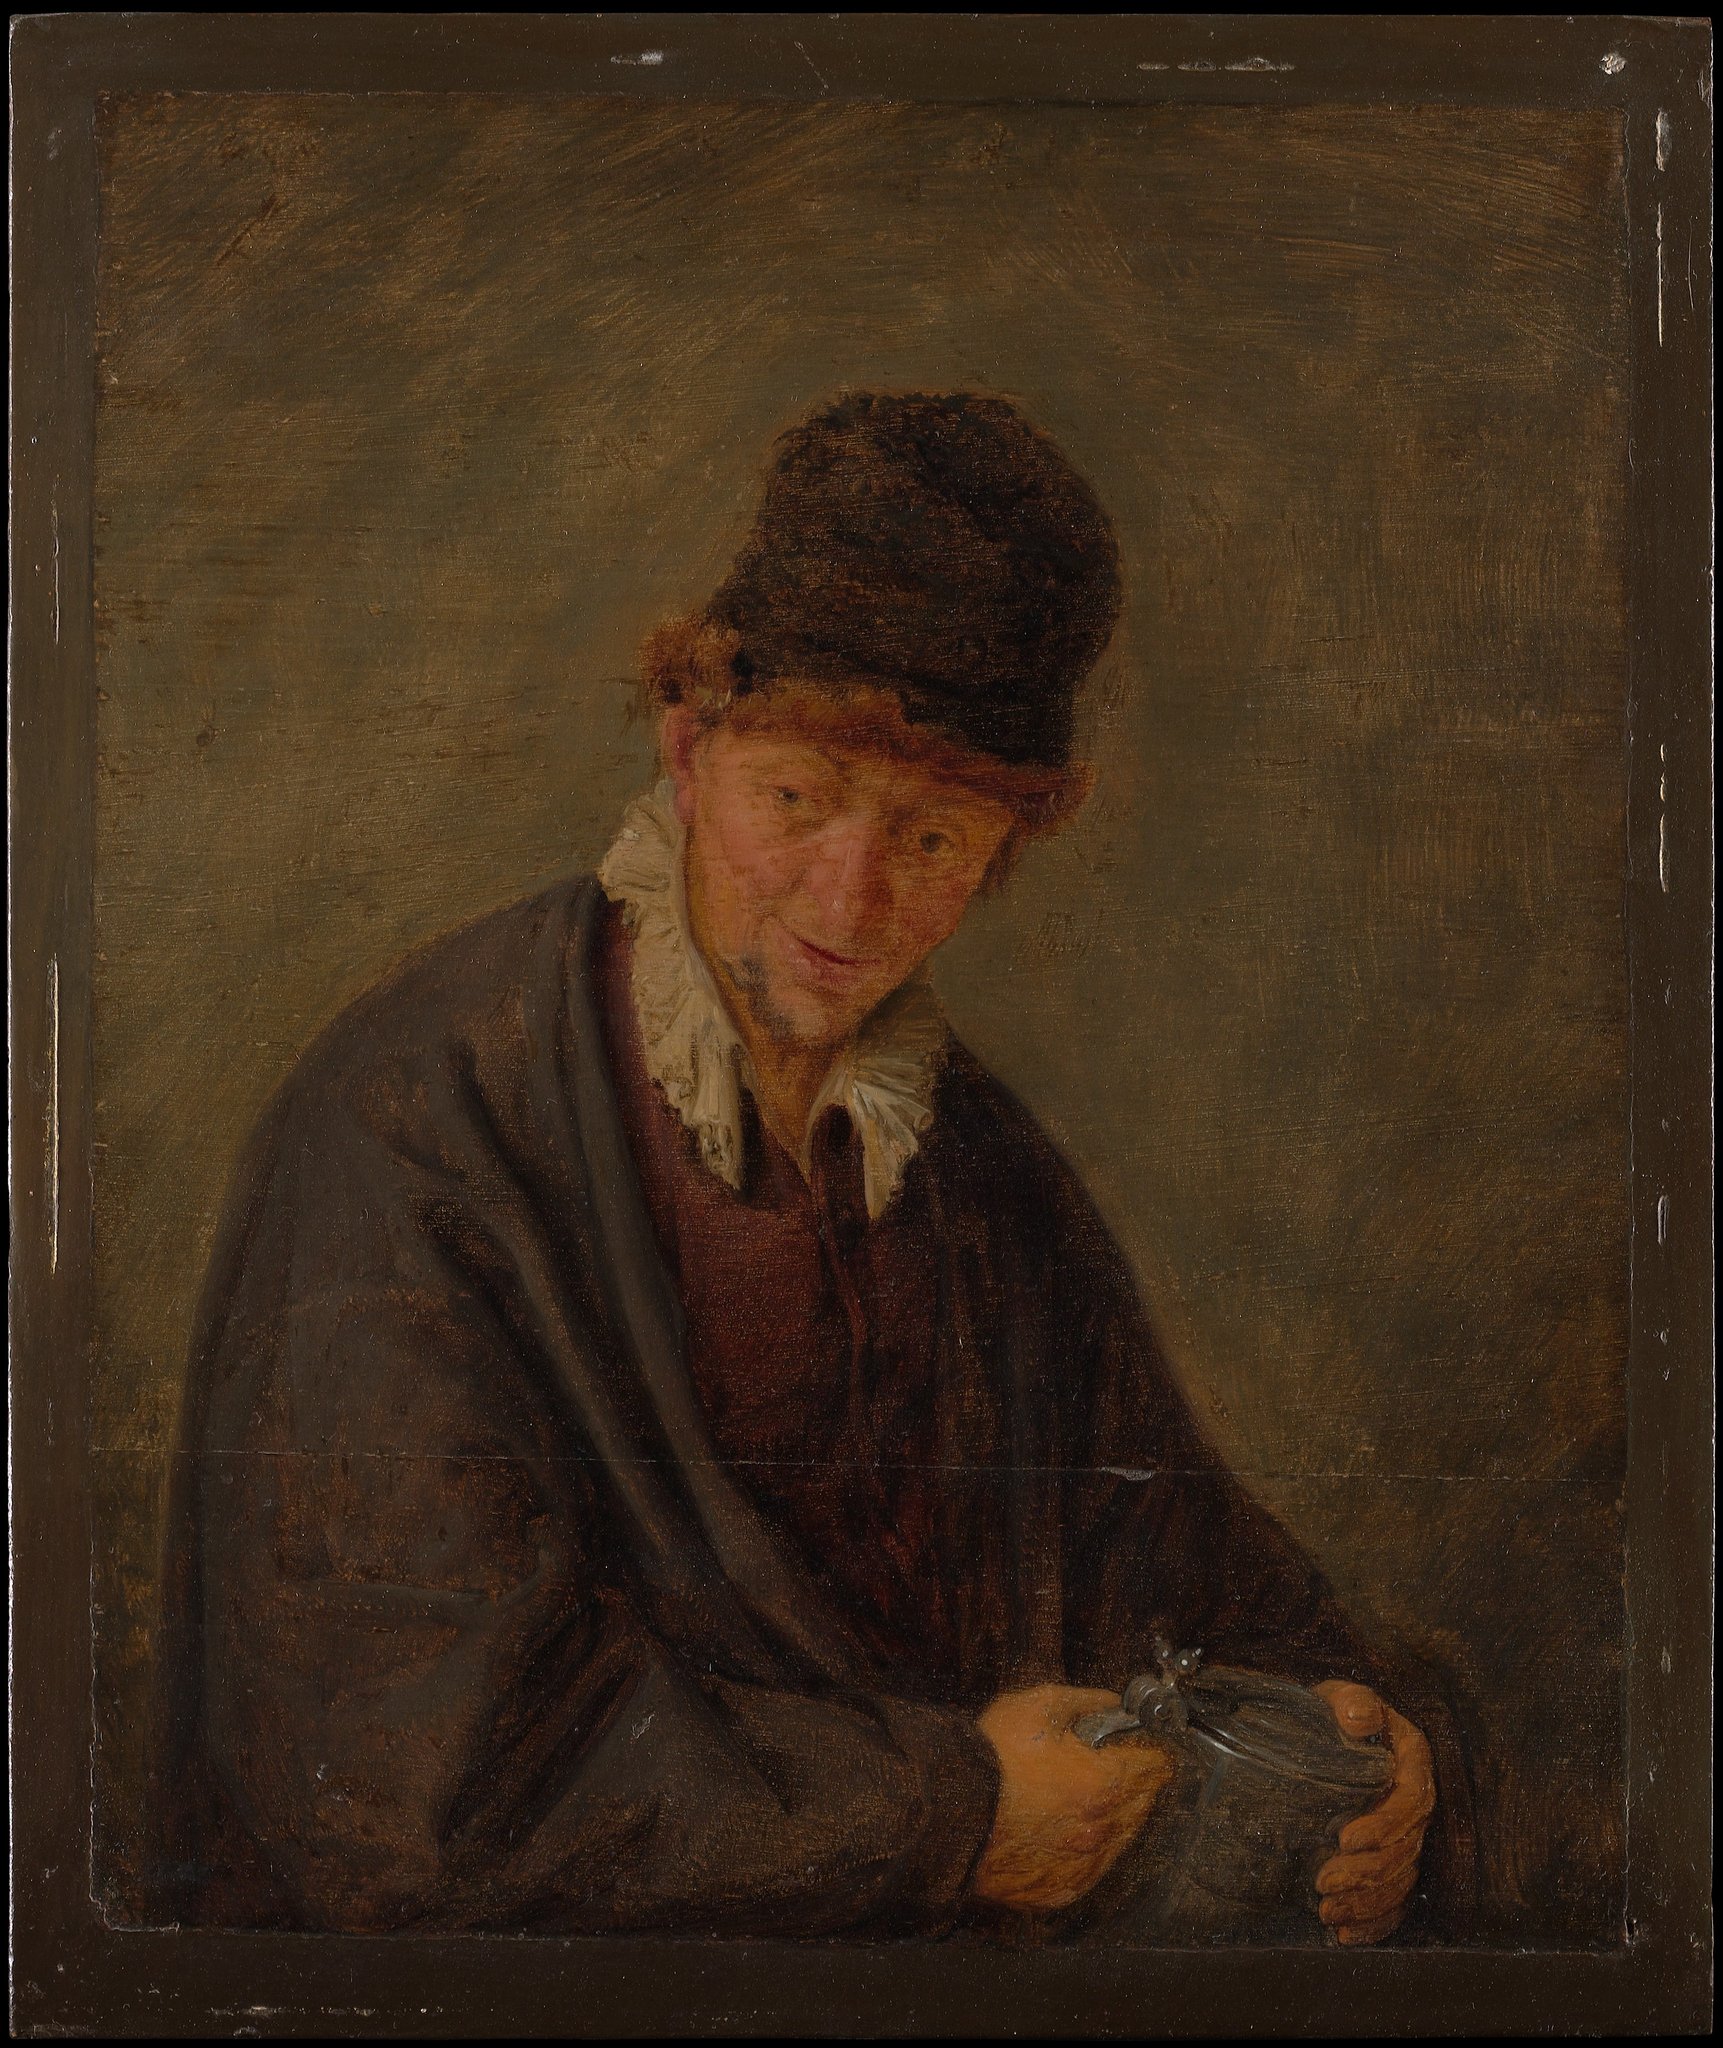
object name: painting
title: Man with a Tankard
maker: adriaen van ostade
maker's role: artist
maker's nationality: dutch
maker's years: 1610-1685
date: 1650-1699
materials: oil, wood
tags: men,portraits